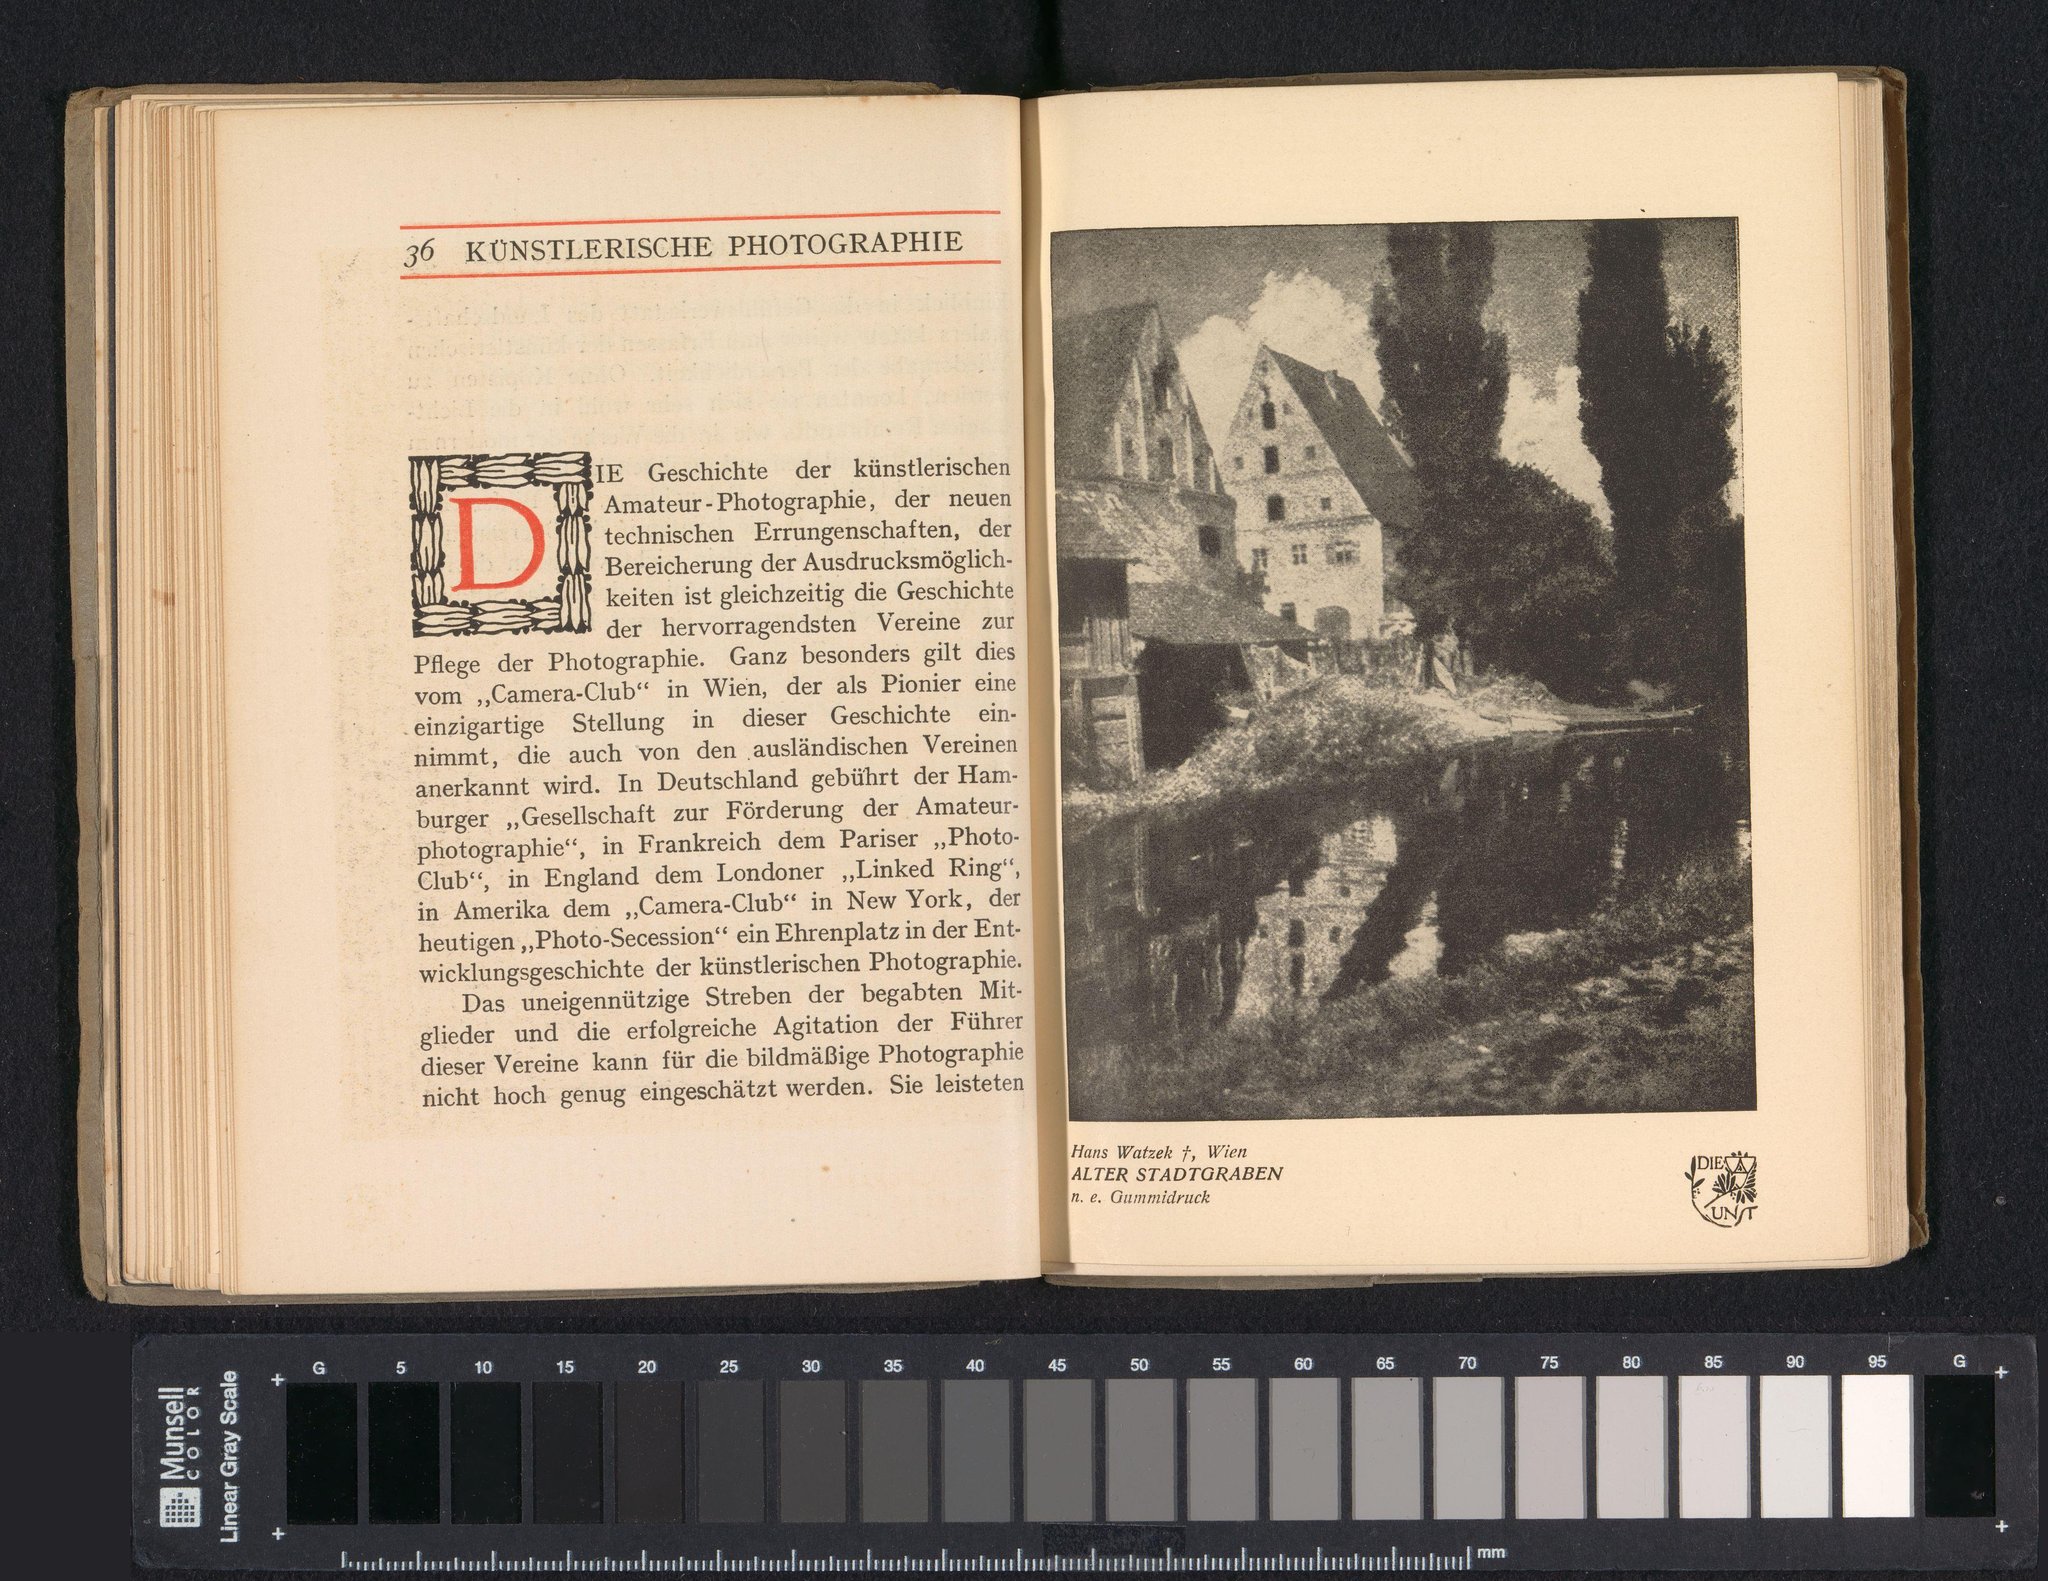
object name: page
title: Alter stadtgraben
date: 1880-1907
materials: paper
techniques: autotype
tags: city-view, and landscape with man-made constructions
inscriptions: inscription: ‘n.e. Gummidruck.’